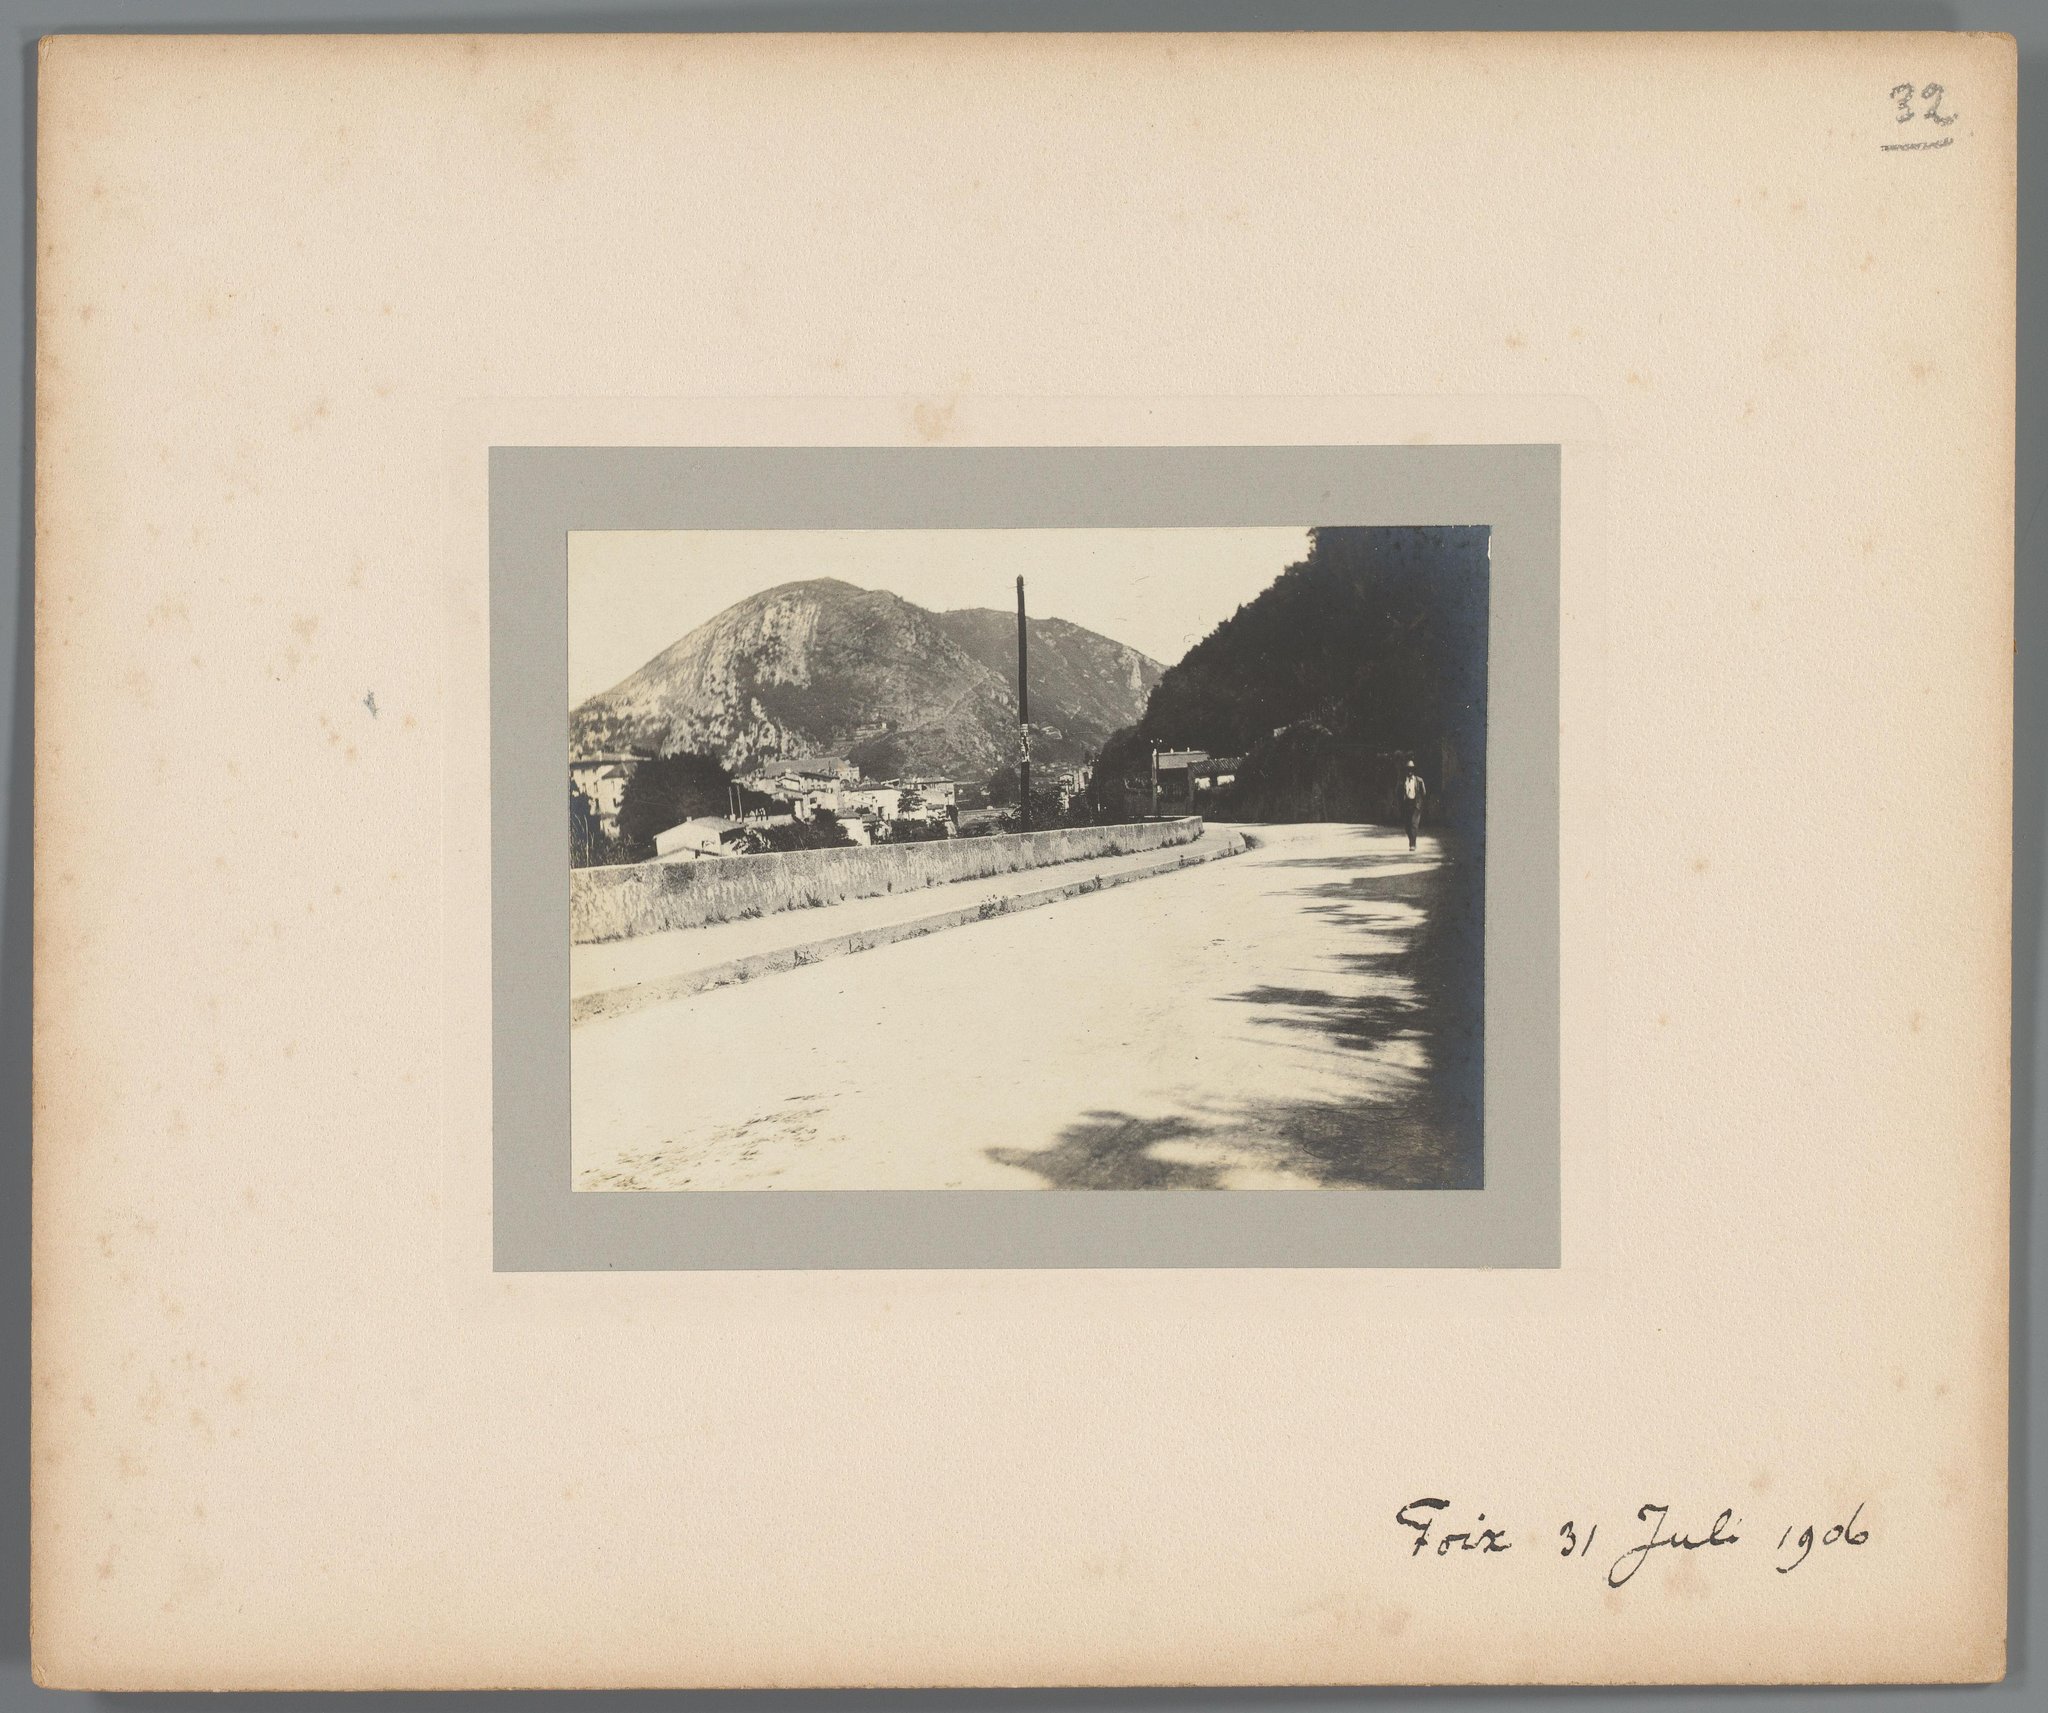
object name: photograph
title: Gezicht op Foix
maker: françois buys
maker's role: advocaat, amateurfotograaf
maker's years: 1871-1934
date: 1906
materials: paper, cardboard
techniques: gelatin silver print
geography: foix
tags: city-view in general; 'veduta'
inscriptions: number: ‘32’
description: Deze foto maakt deel uit van een groep van 49 foto's.